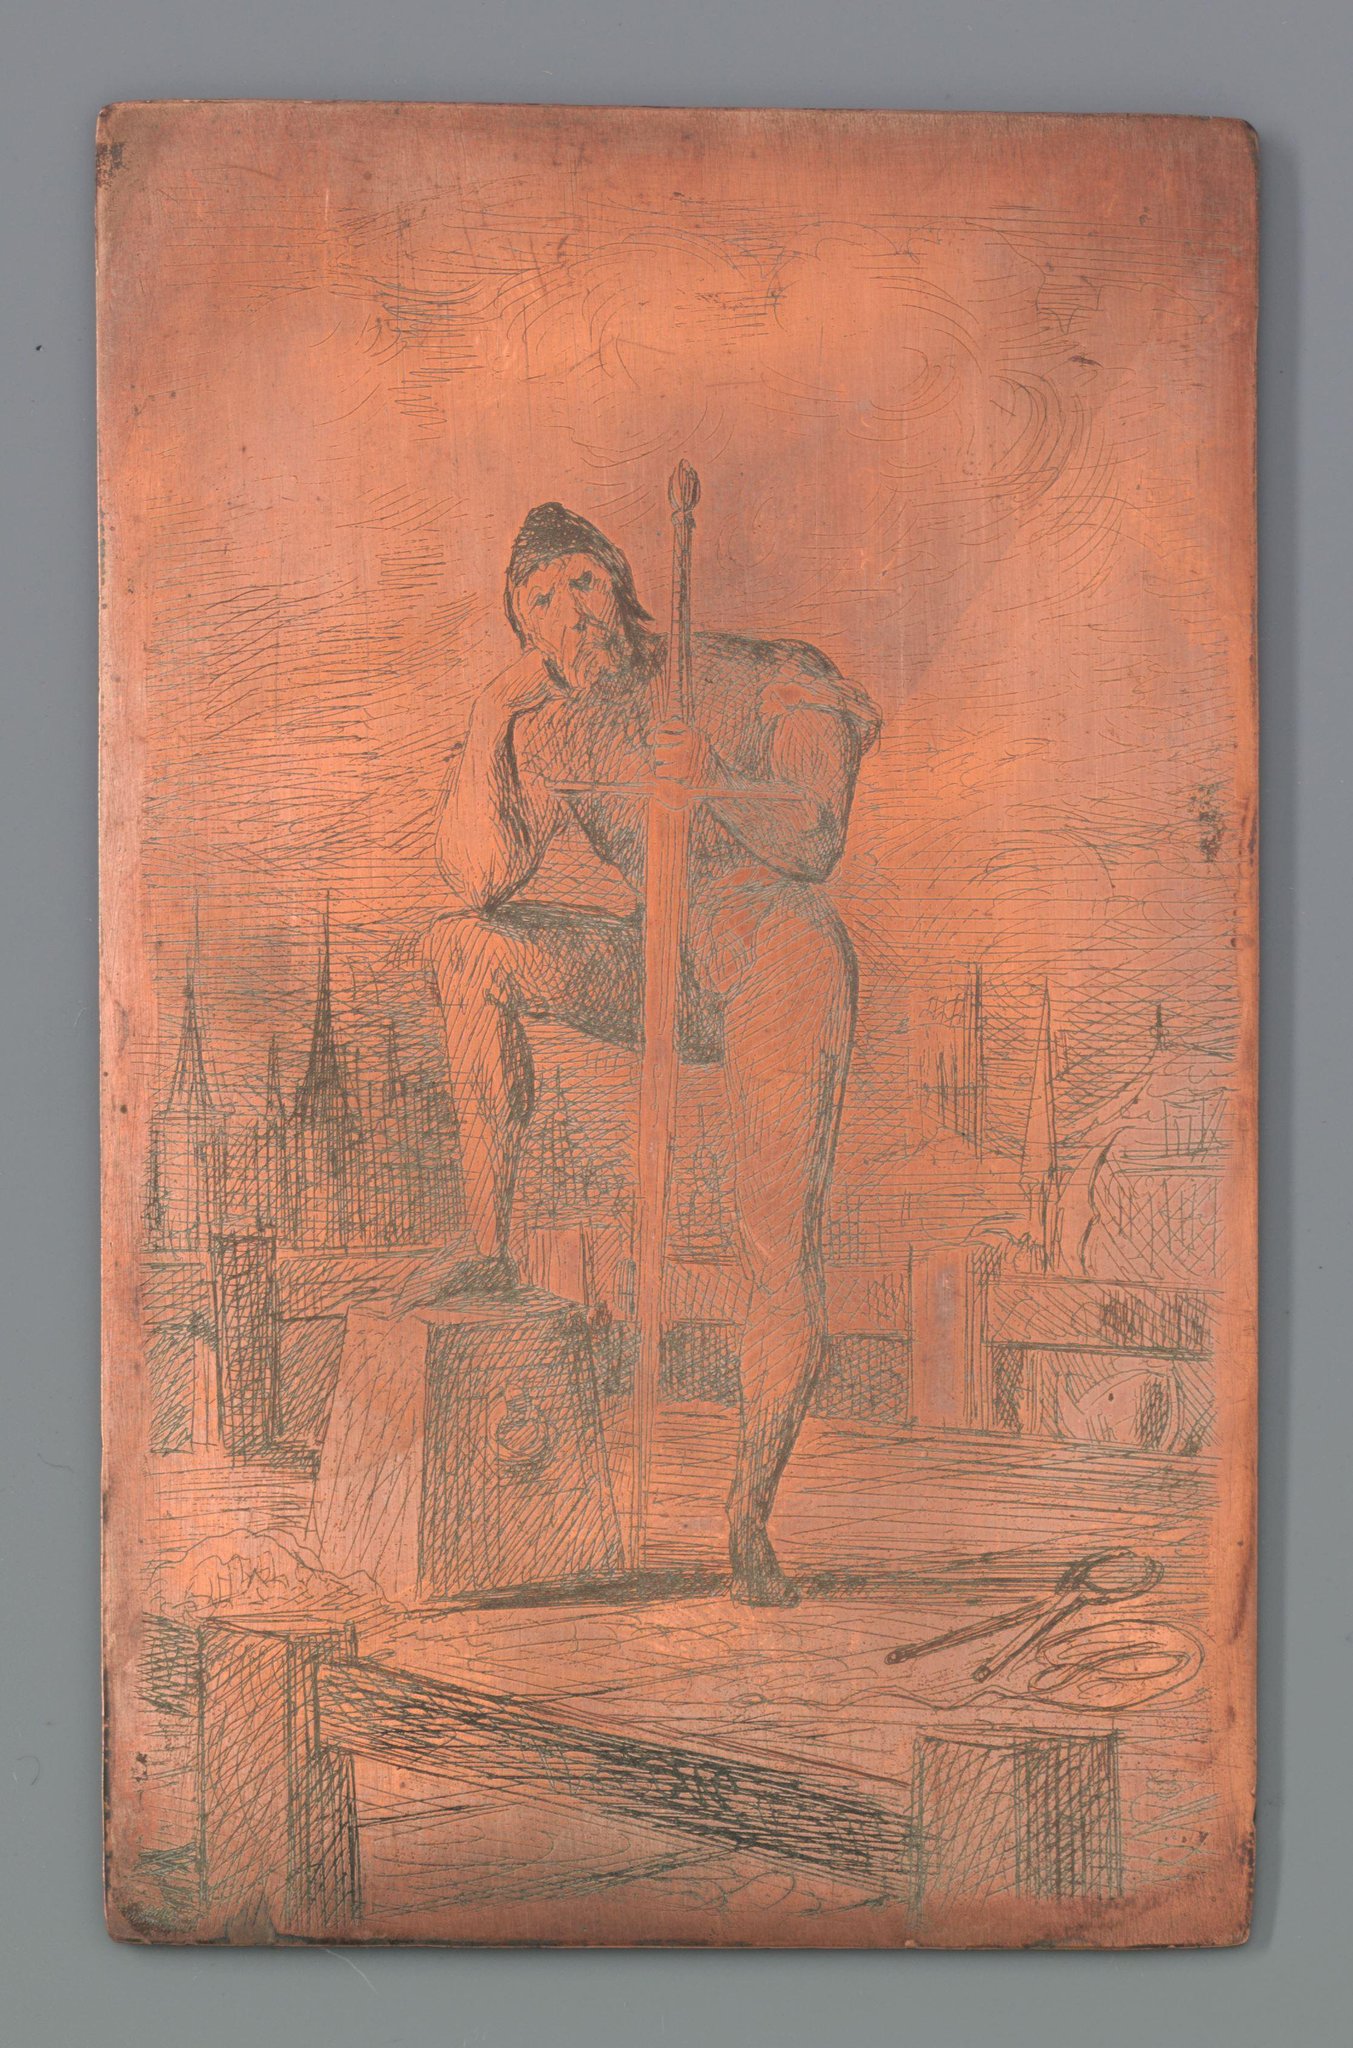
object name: copper plate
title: Man met groot zwaard, leunend op vierkant blok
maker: w. thomson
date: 1800-1899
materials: copper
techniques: etching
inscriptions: inscription: ‘A complete Set of Roud text C'optes, Written for the use of Schools by W. Thomson. Islington.’